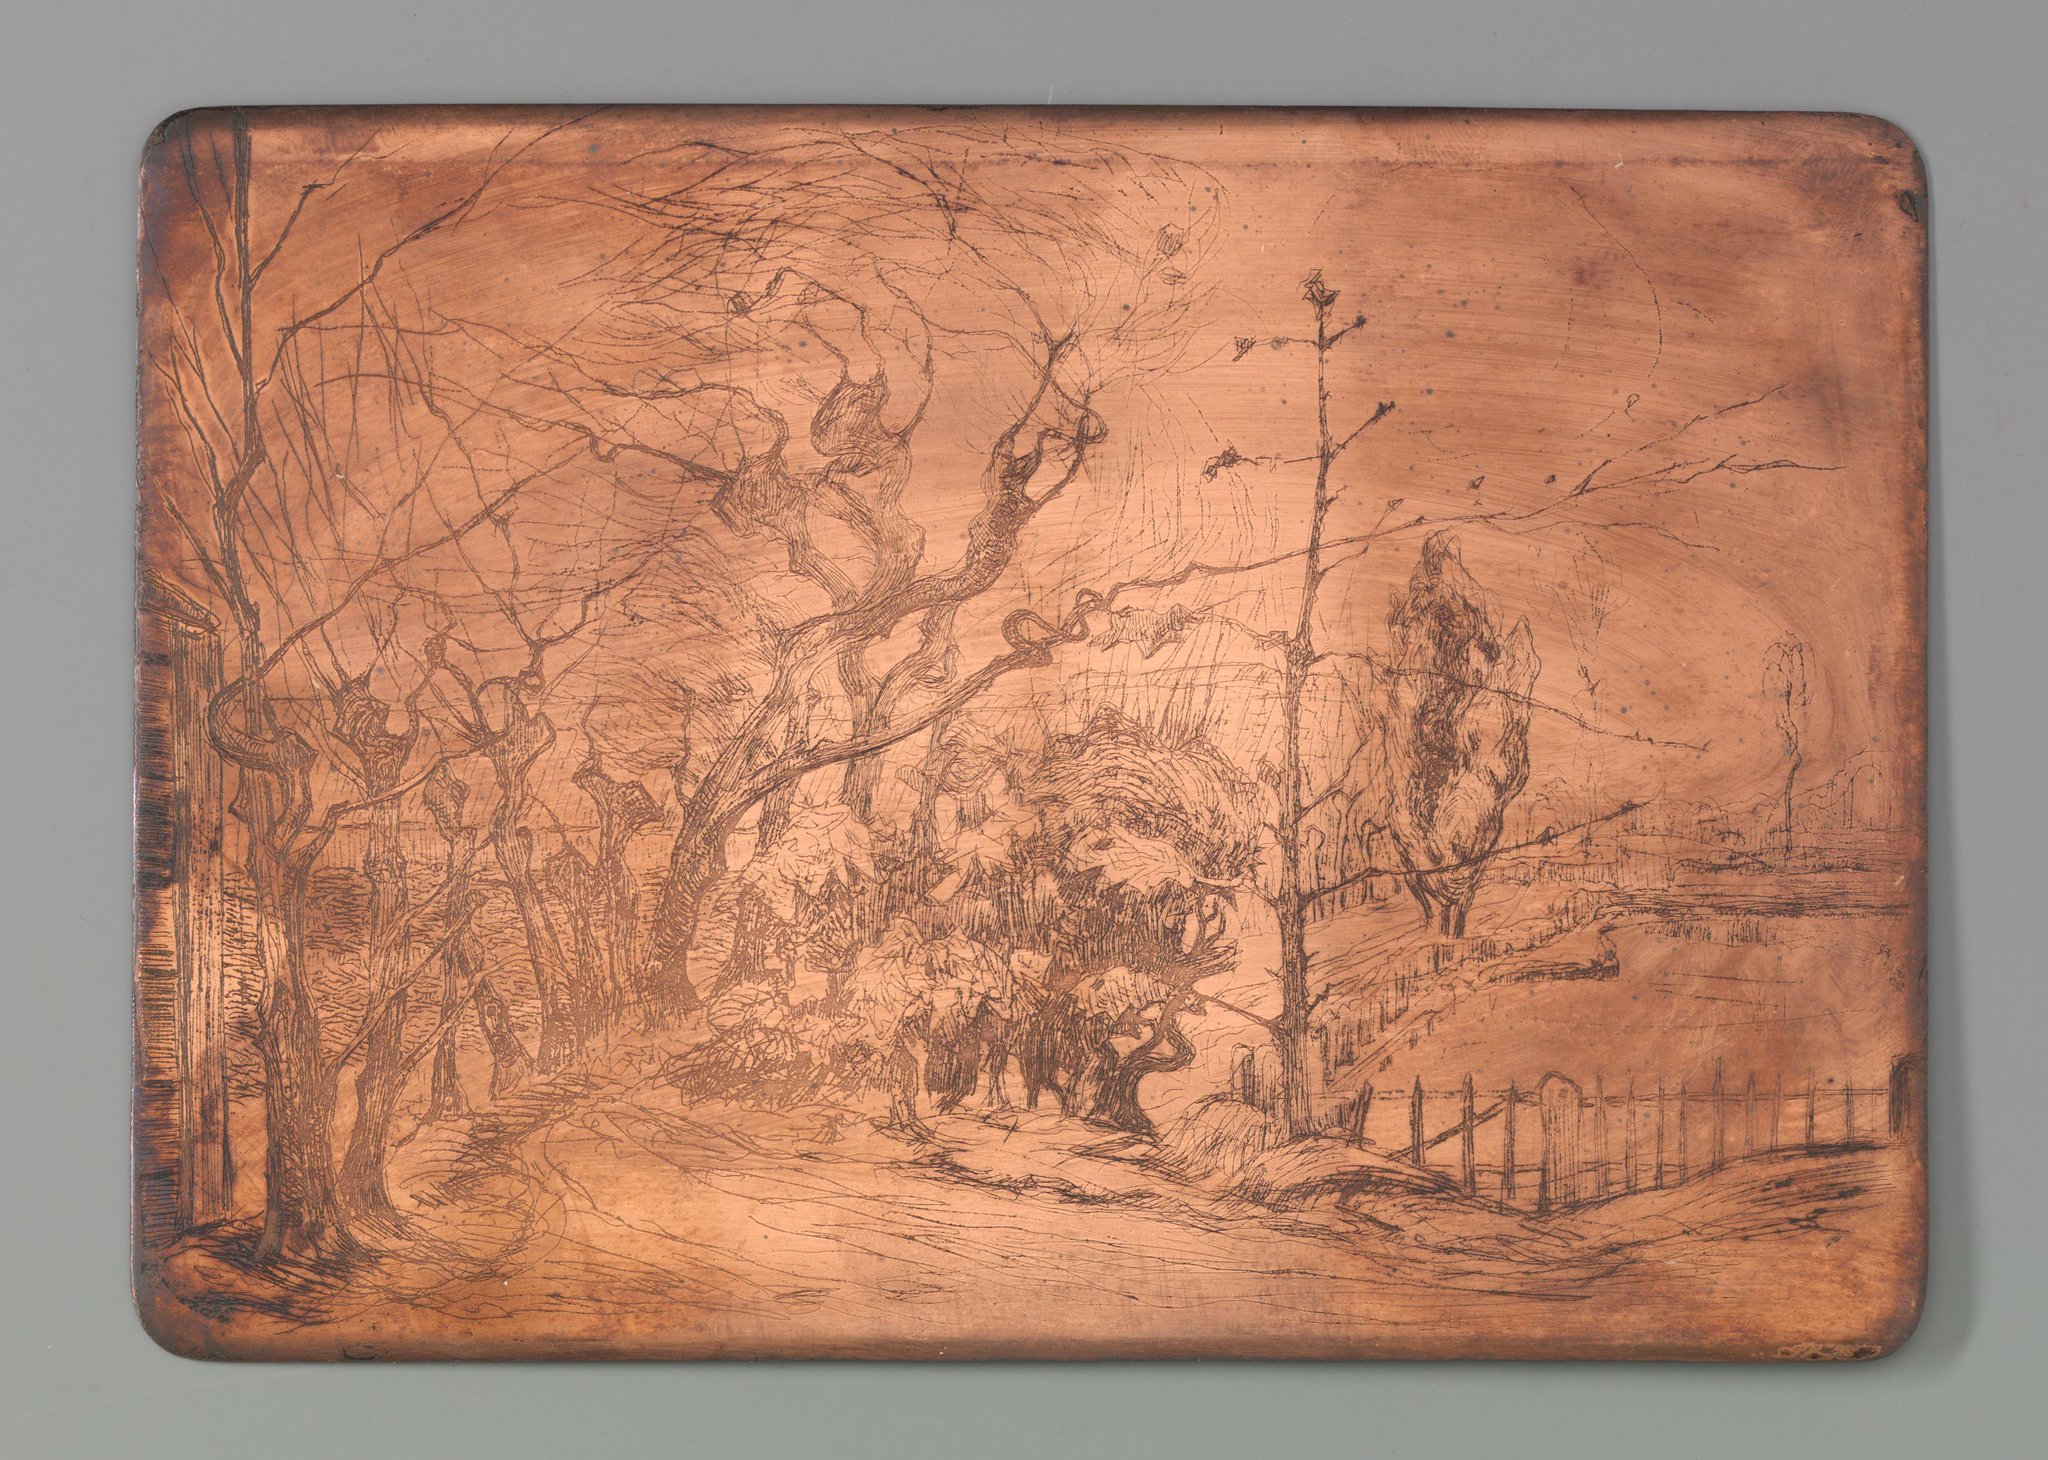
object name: copper plate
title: Tuinpad met wilgen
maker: floris verster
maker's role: draughtsman, painter, print maker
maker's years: 1861-1927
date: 1890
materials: copper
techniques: etching